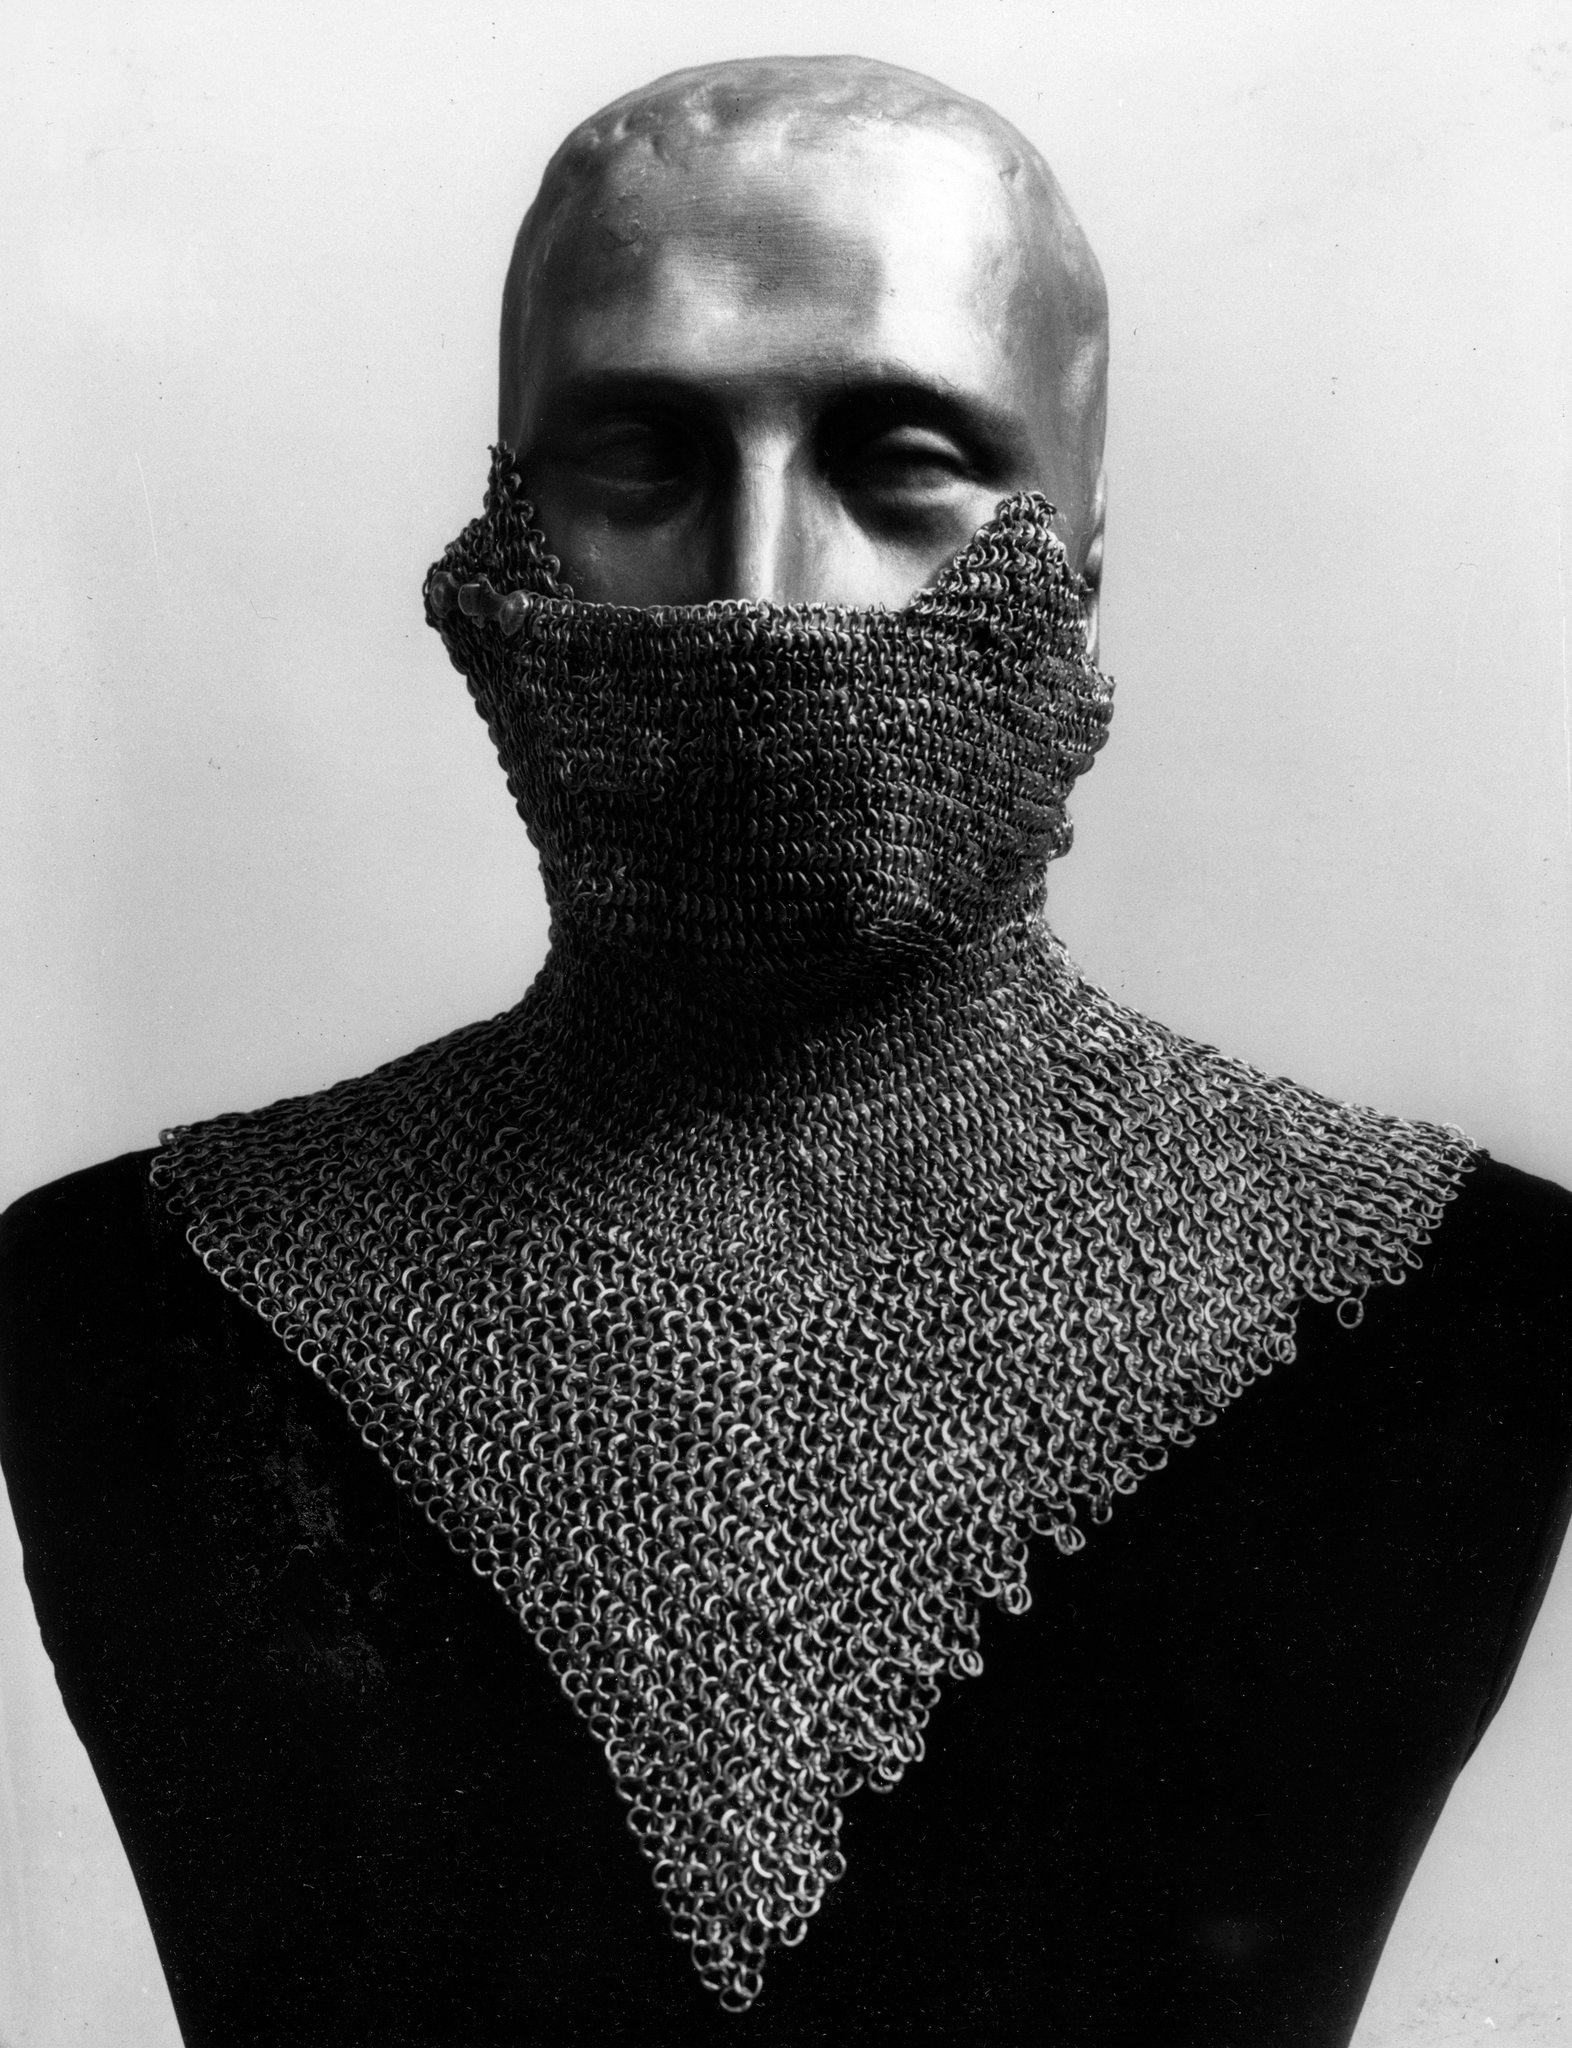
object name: face defense of mail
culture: german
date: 1401-1500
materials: brass, iron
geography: germany